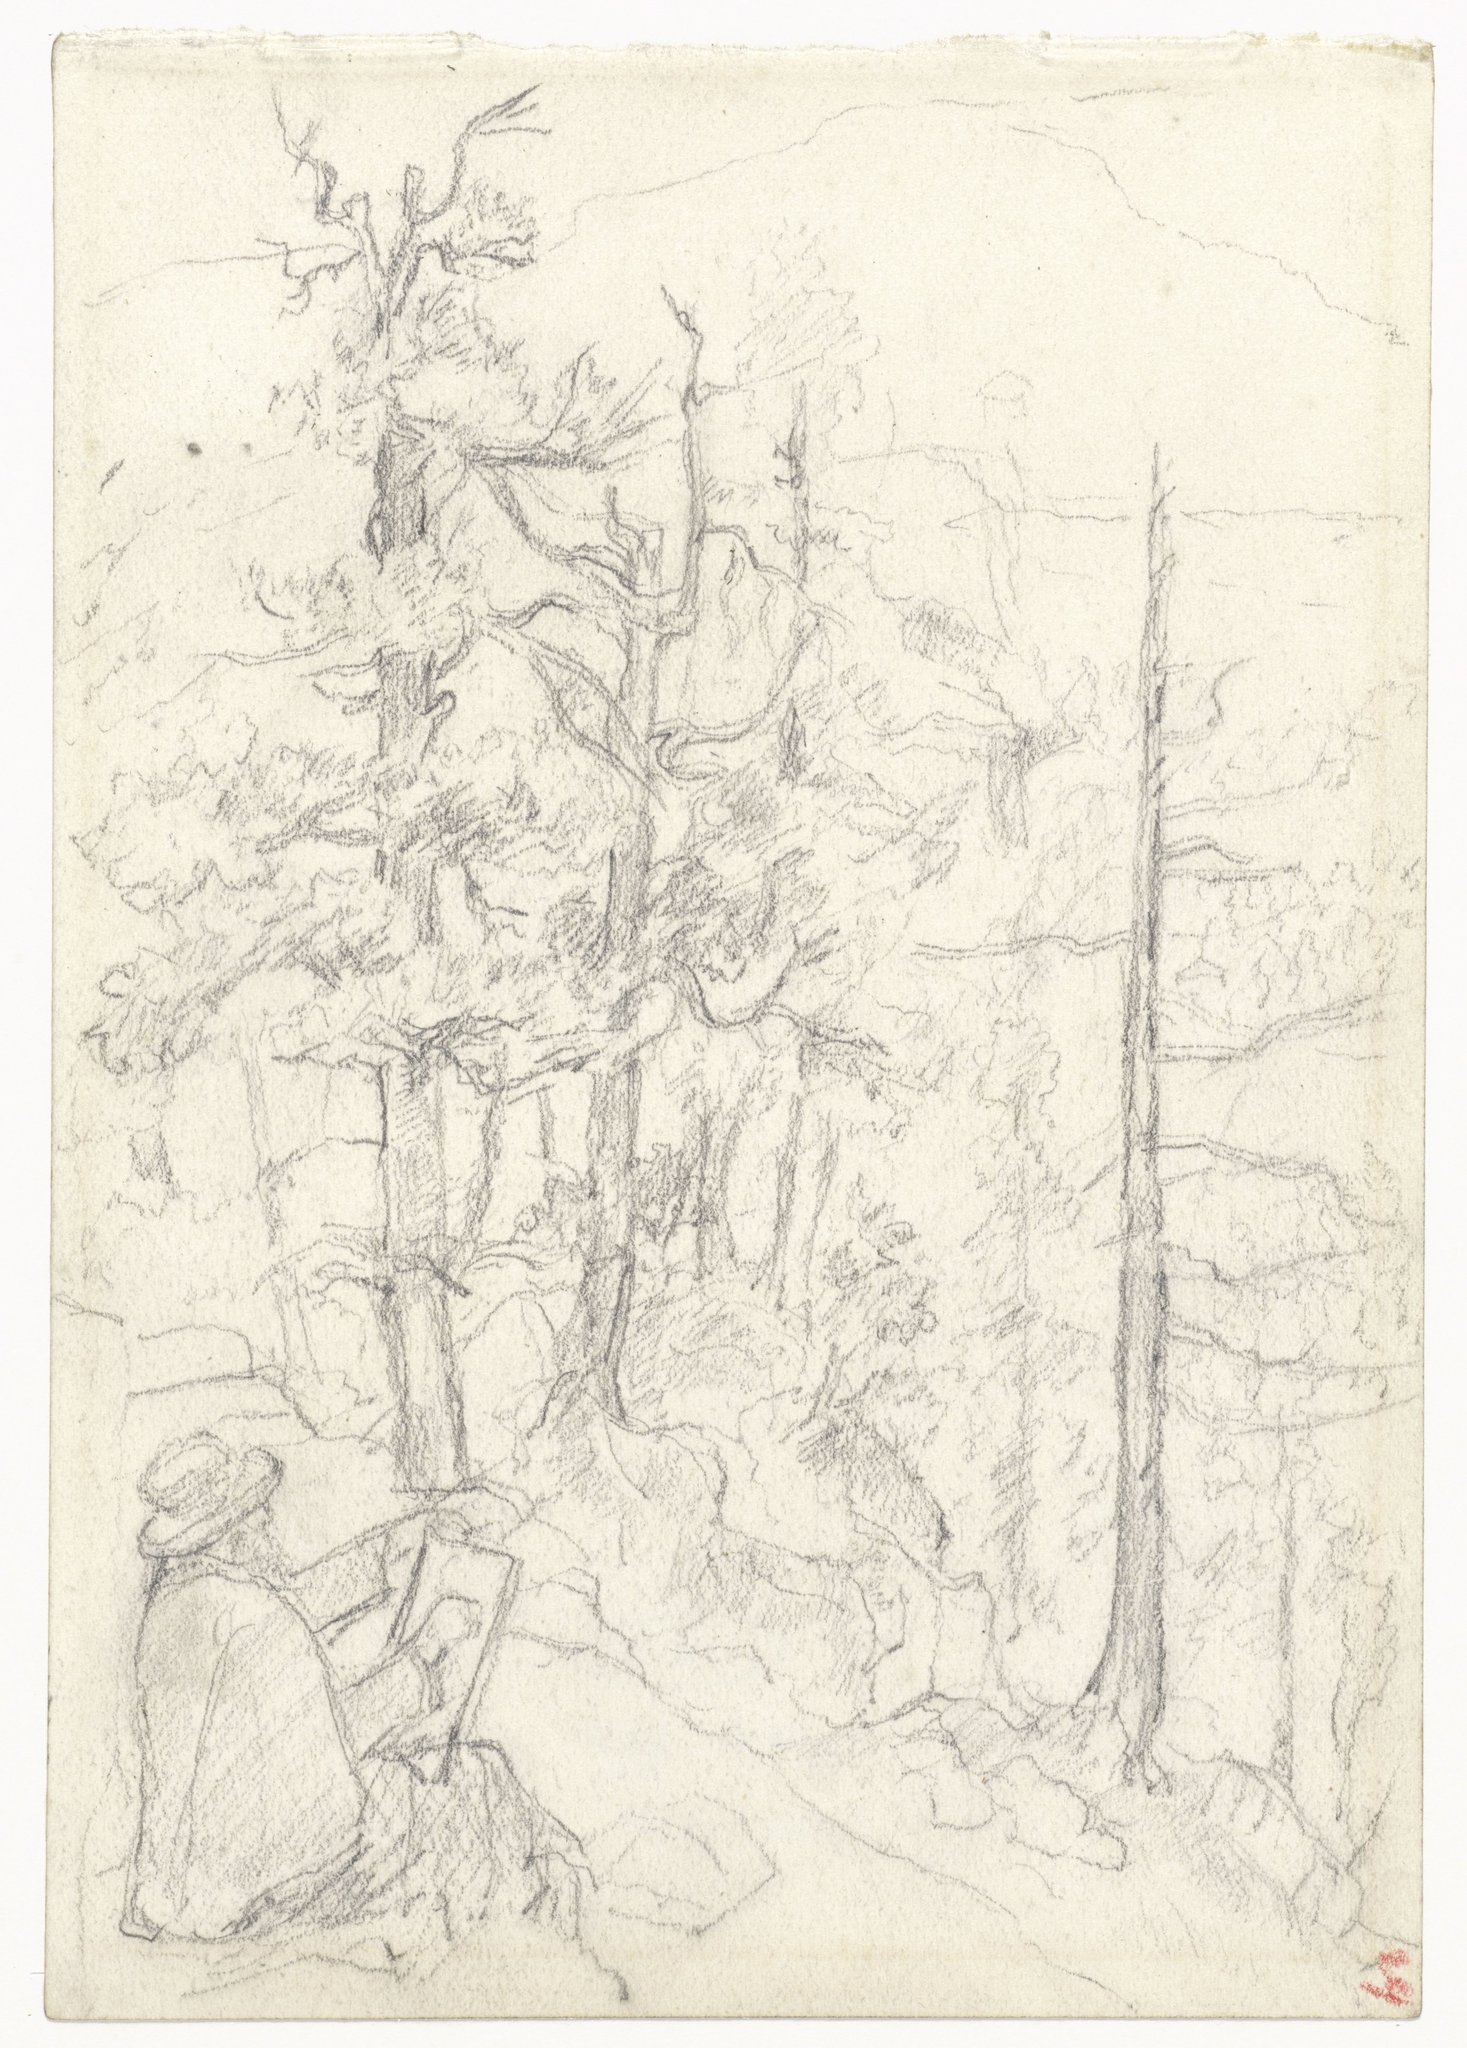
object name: drawing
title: Bos met zittende tekenaar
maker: jozef israëls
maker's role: draughtsman, painter, print maker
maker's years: 1824-1911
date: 1834-1911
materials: paper, pencil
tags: forest, wood, draughtsman at work - cc - out of doors